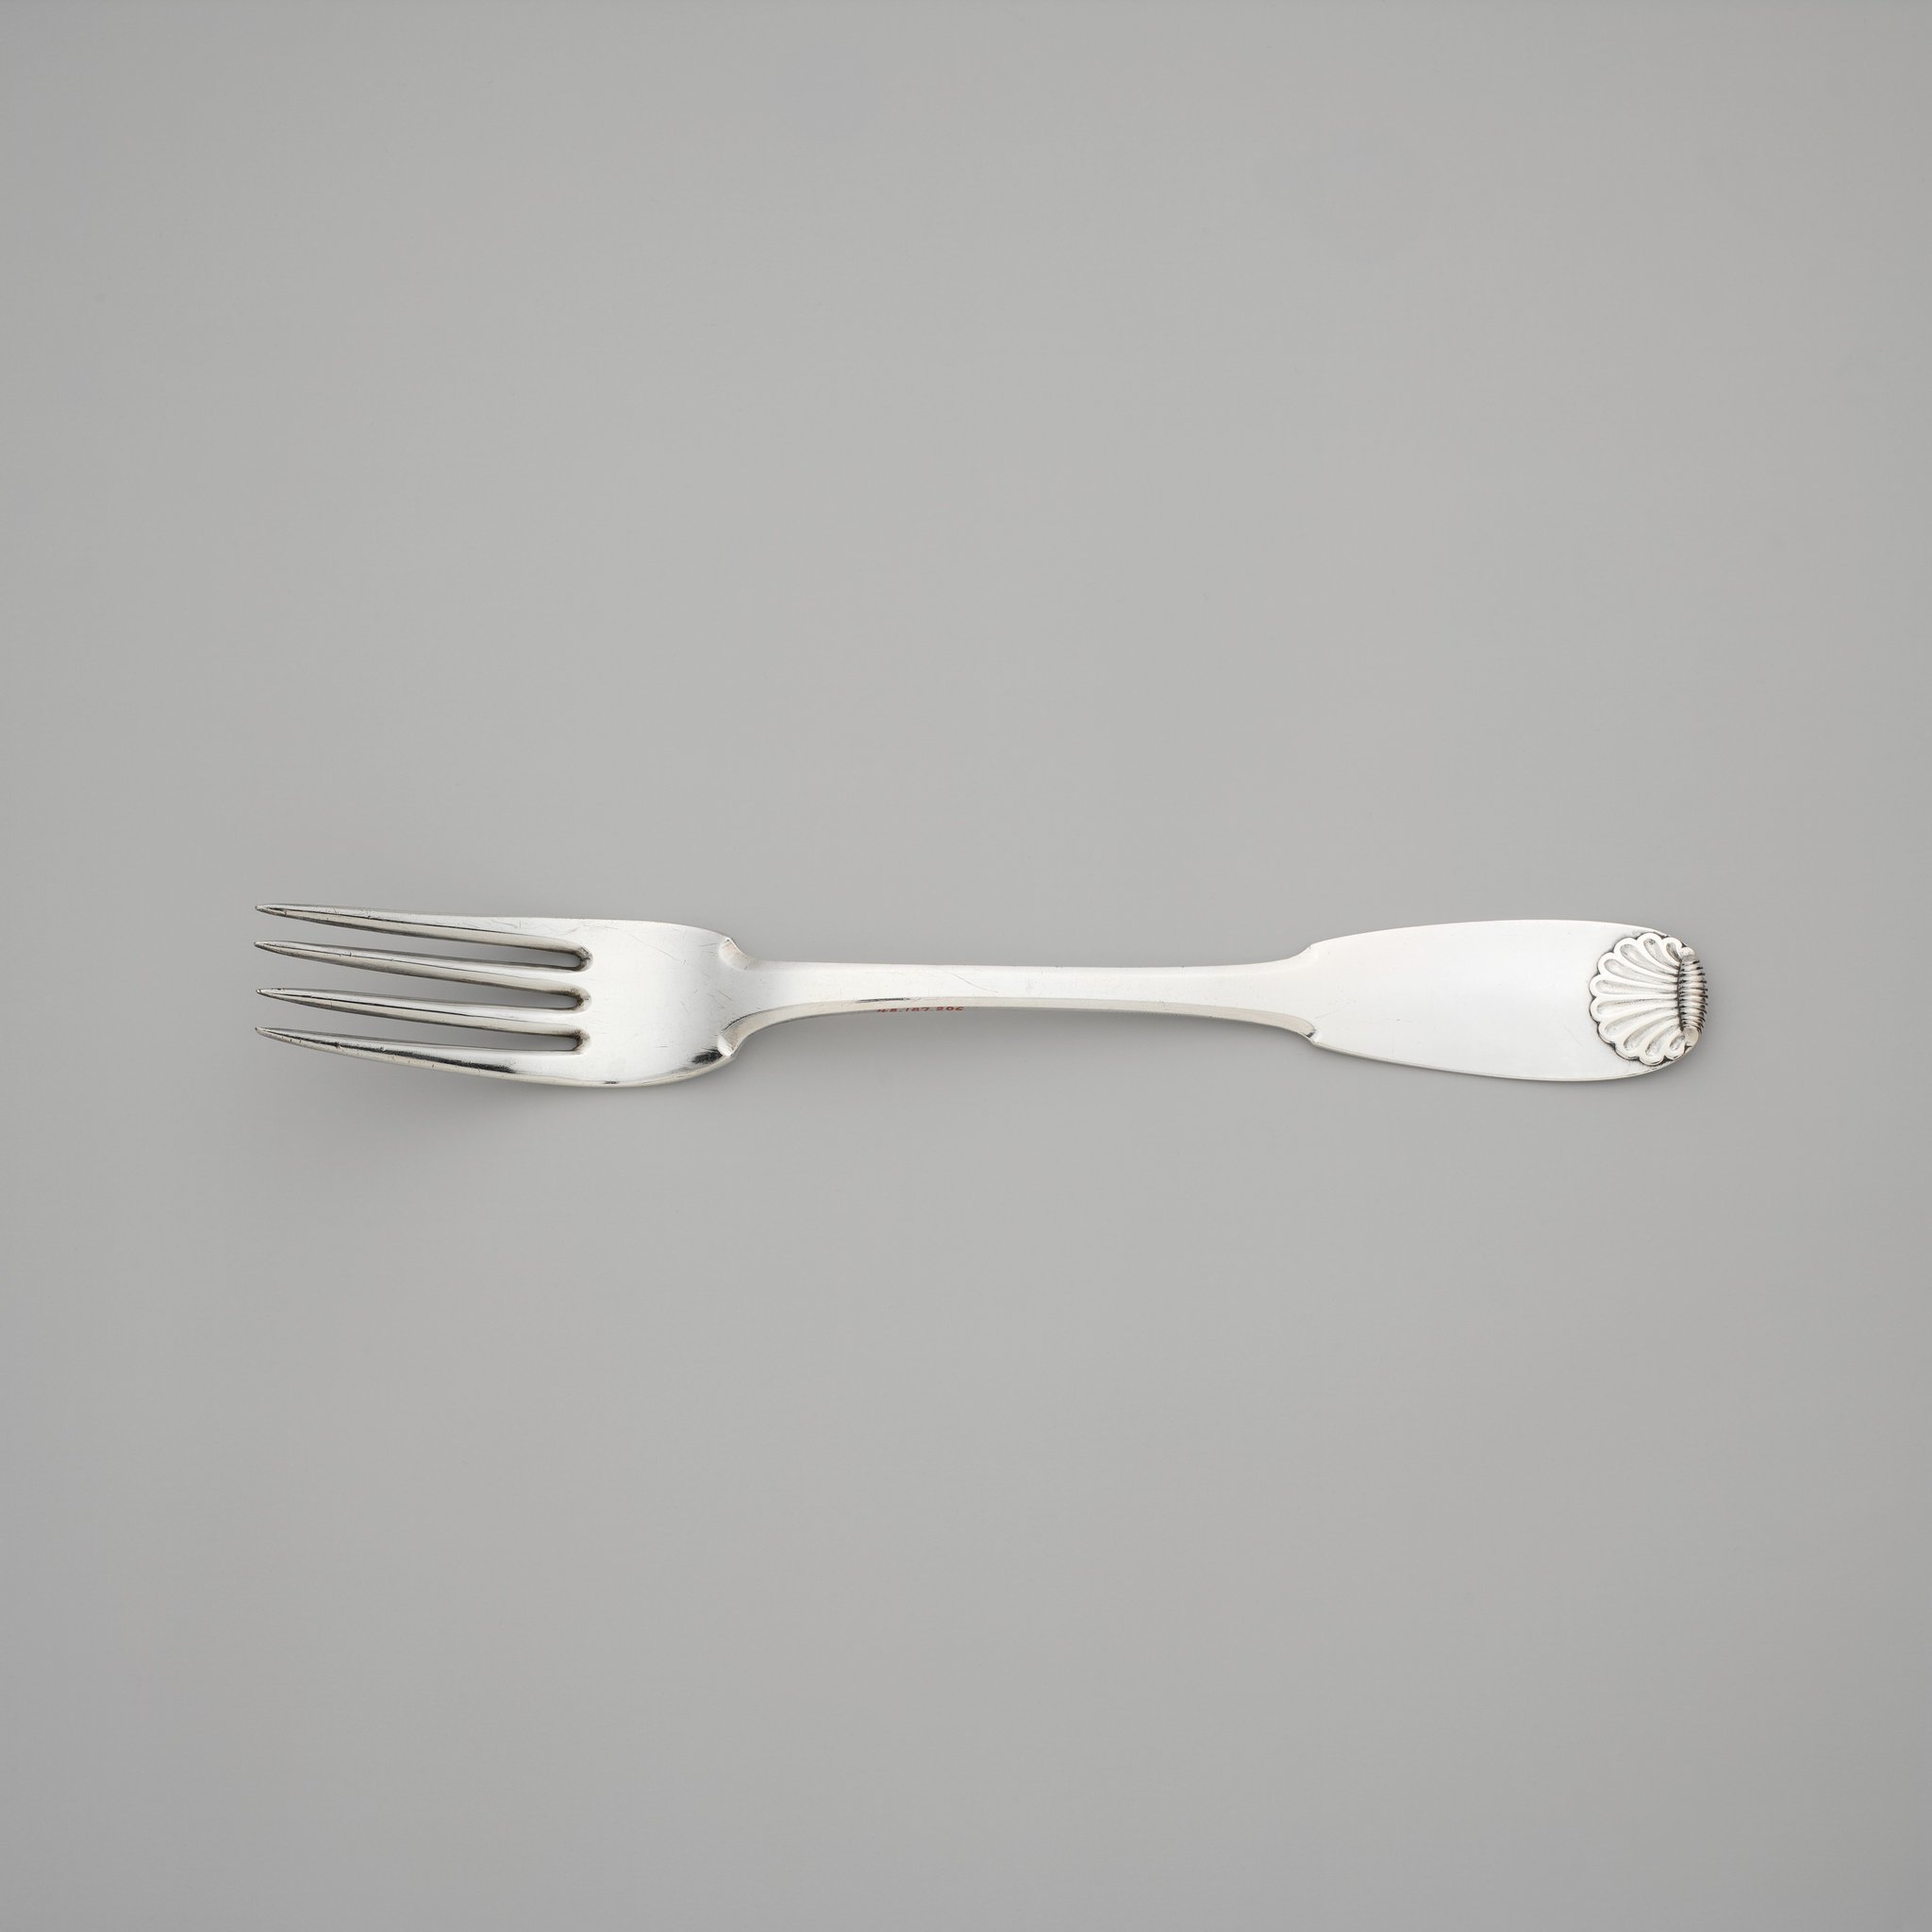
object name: serving fork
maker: melchior latil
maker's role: maker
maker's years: 1682-1782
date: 1775-1776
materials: silver